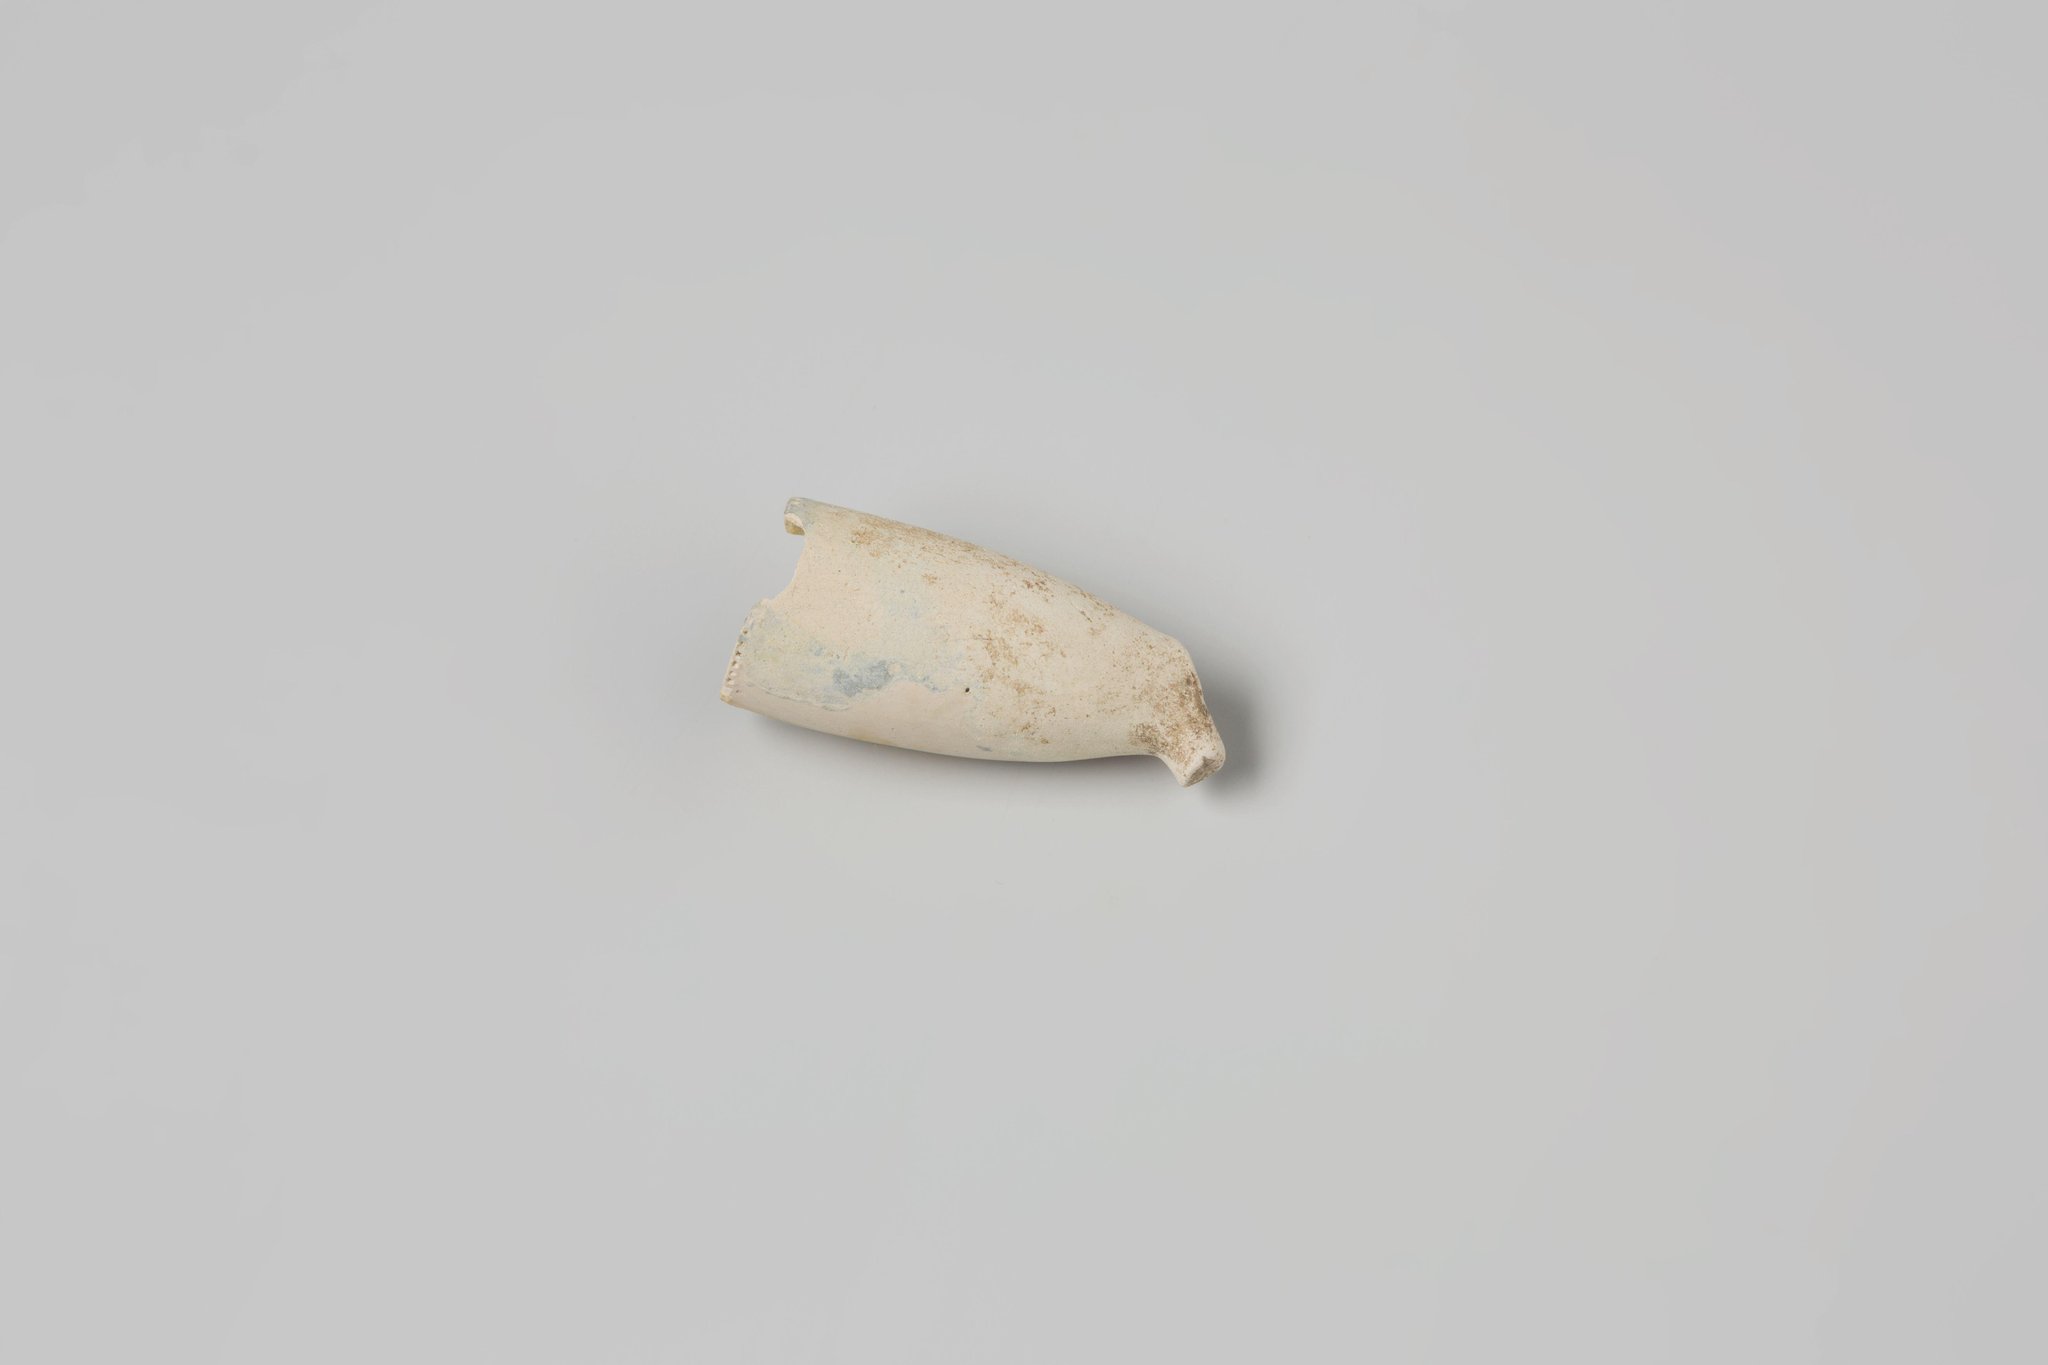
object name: pipe bowl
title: Fragment van een pijpenkop uit het wrak van de Oost-Indiëvaarder 't Vliegend Hart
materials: clay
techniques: firing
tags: 't vliegend hart (schip), verenigde oostindische compagnie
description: Eén gebroken kop met onleesbaar hielmerk van een aarden Goudse pijp, gelig verkleurd. Fragments of bowls and stems.